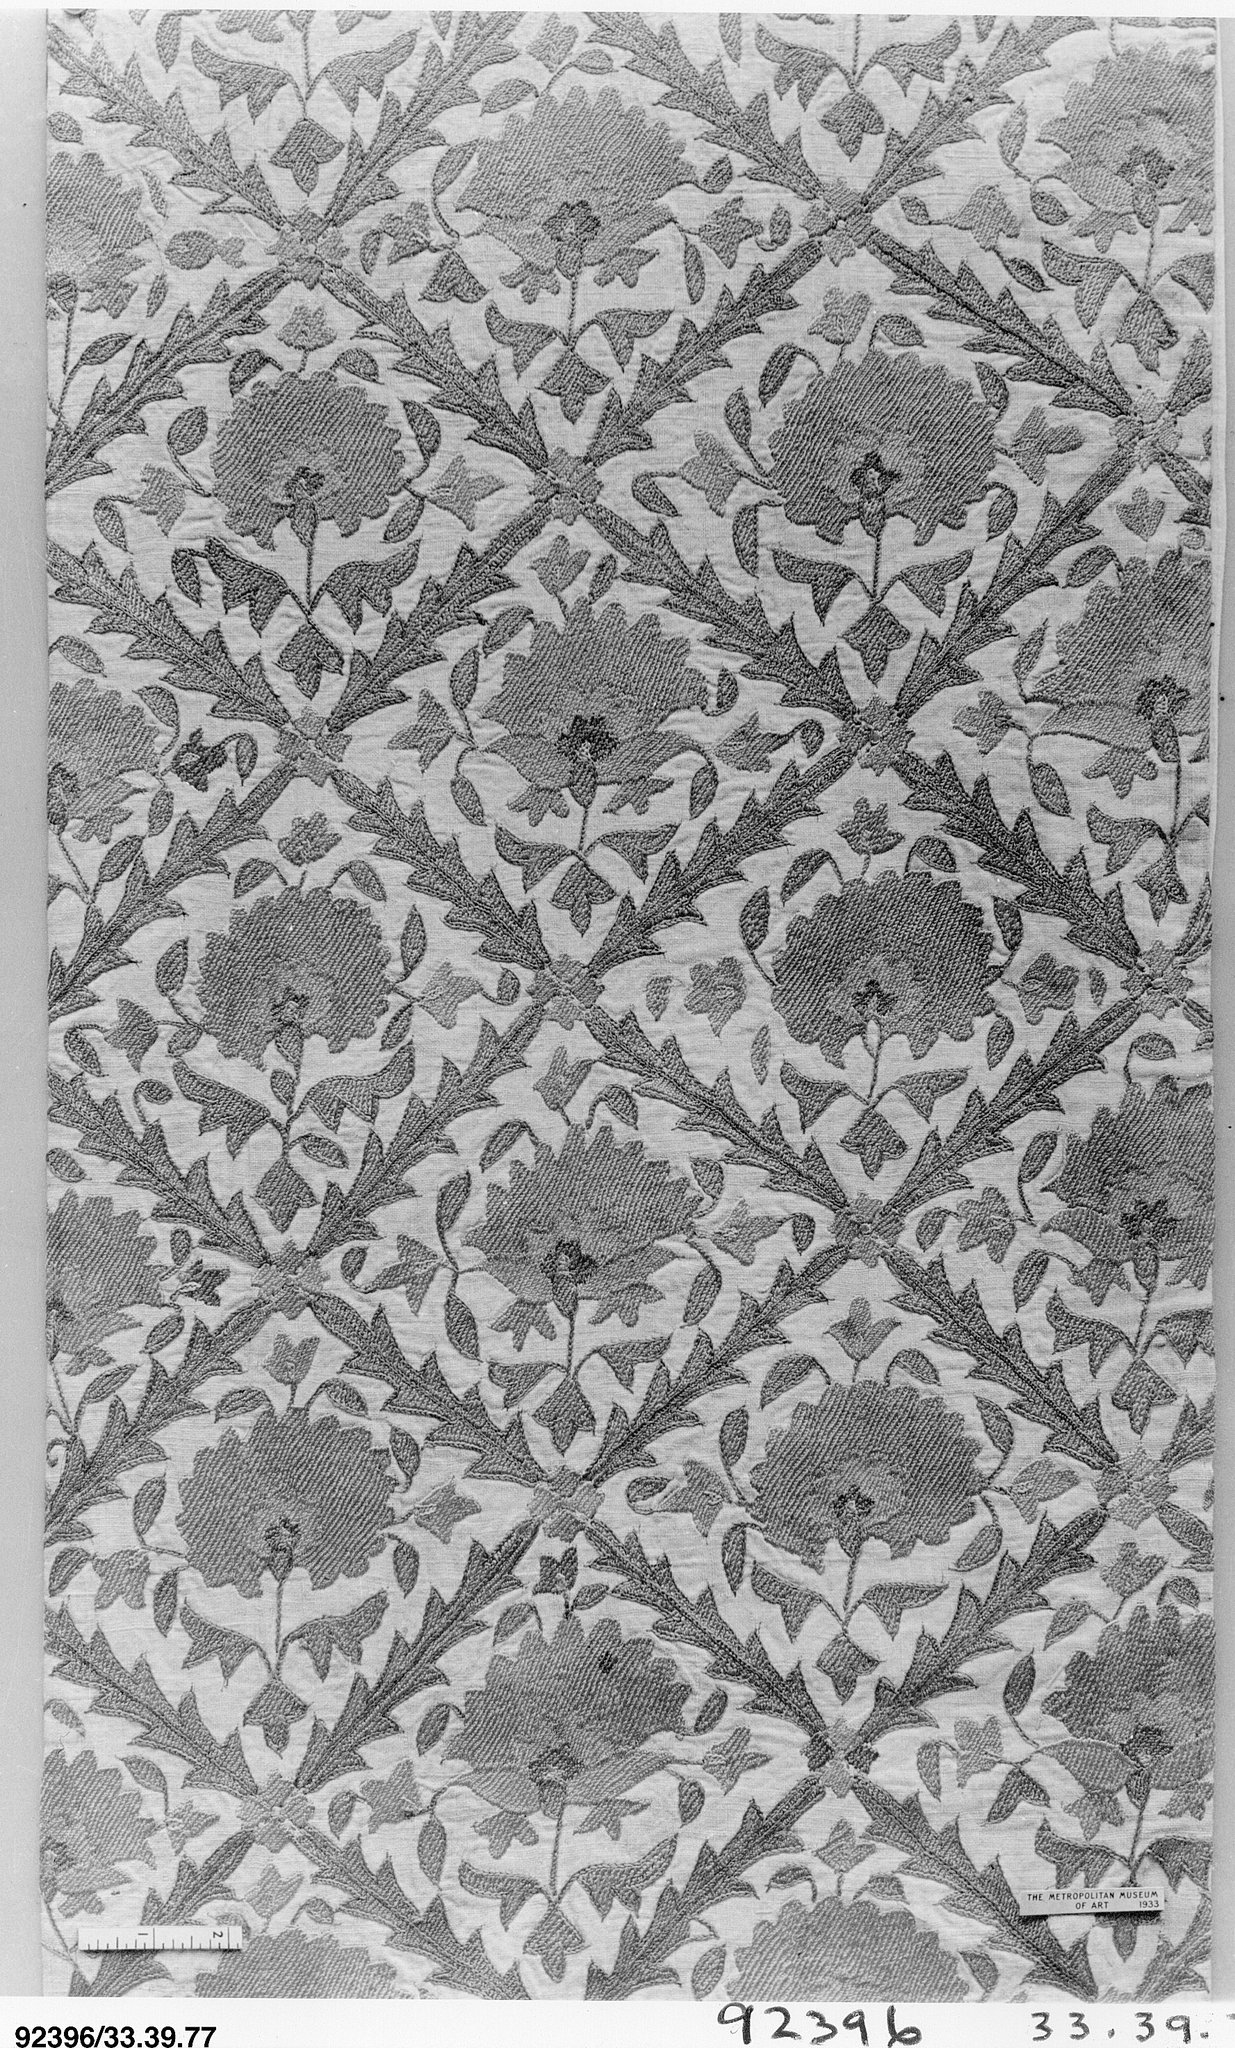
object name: textile fragment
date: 1701-1800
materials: linen, silk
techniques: embroidery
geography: uzbekistan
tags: flowers